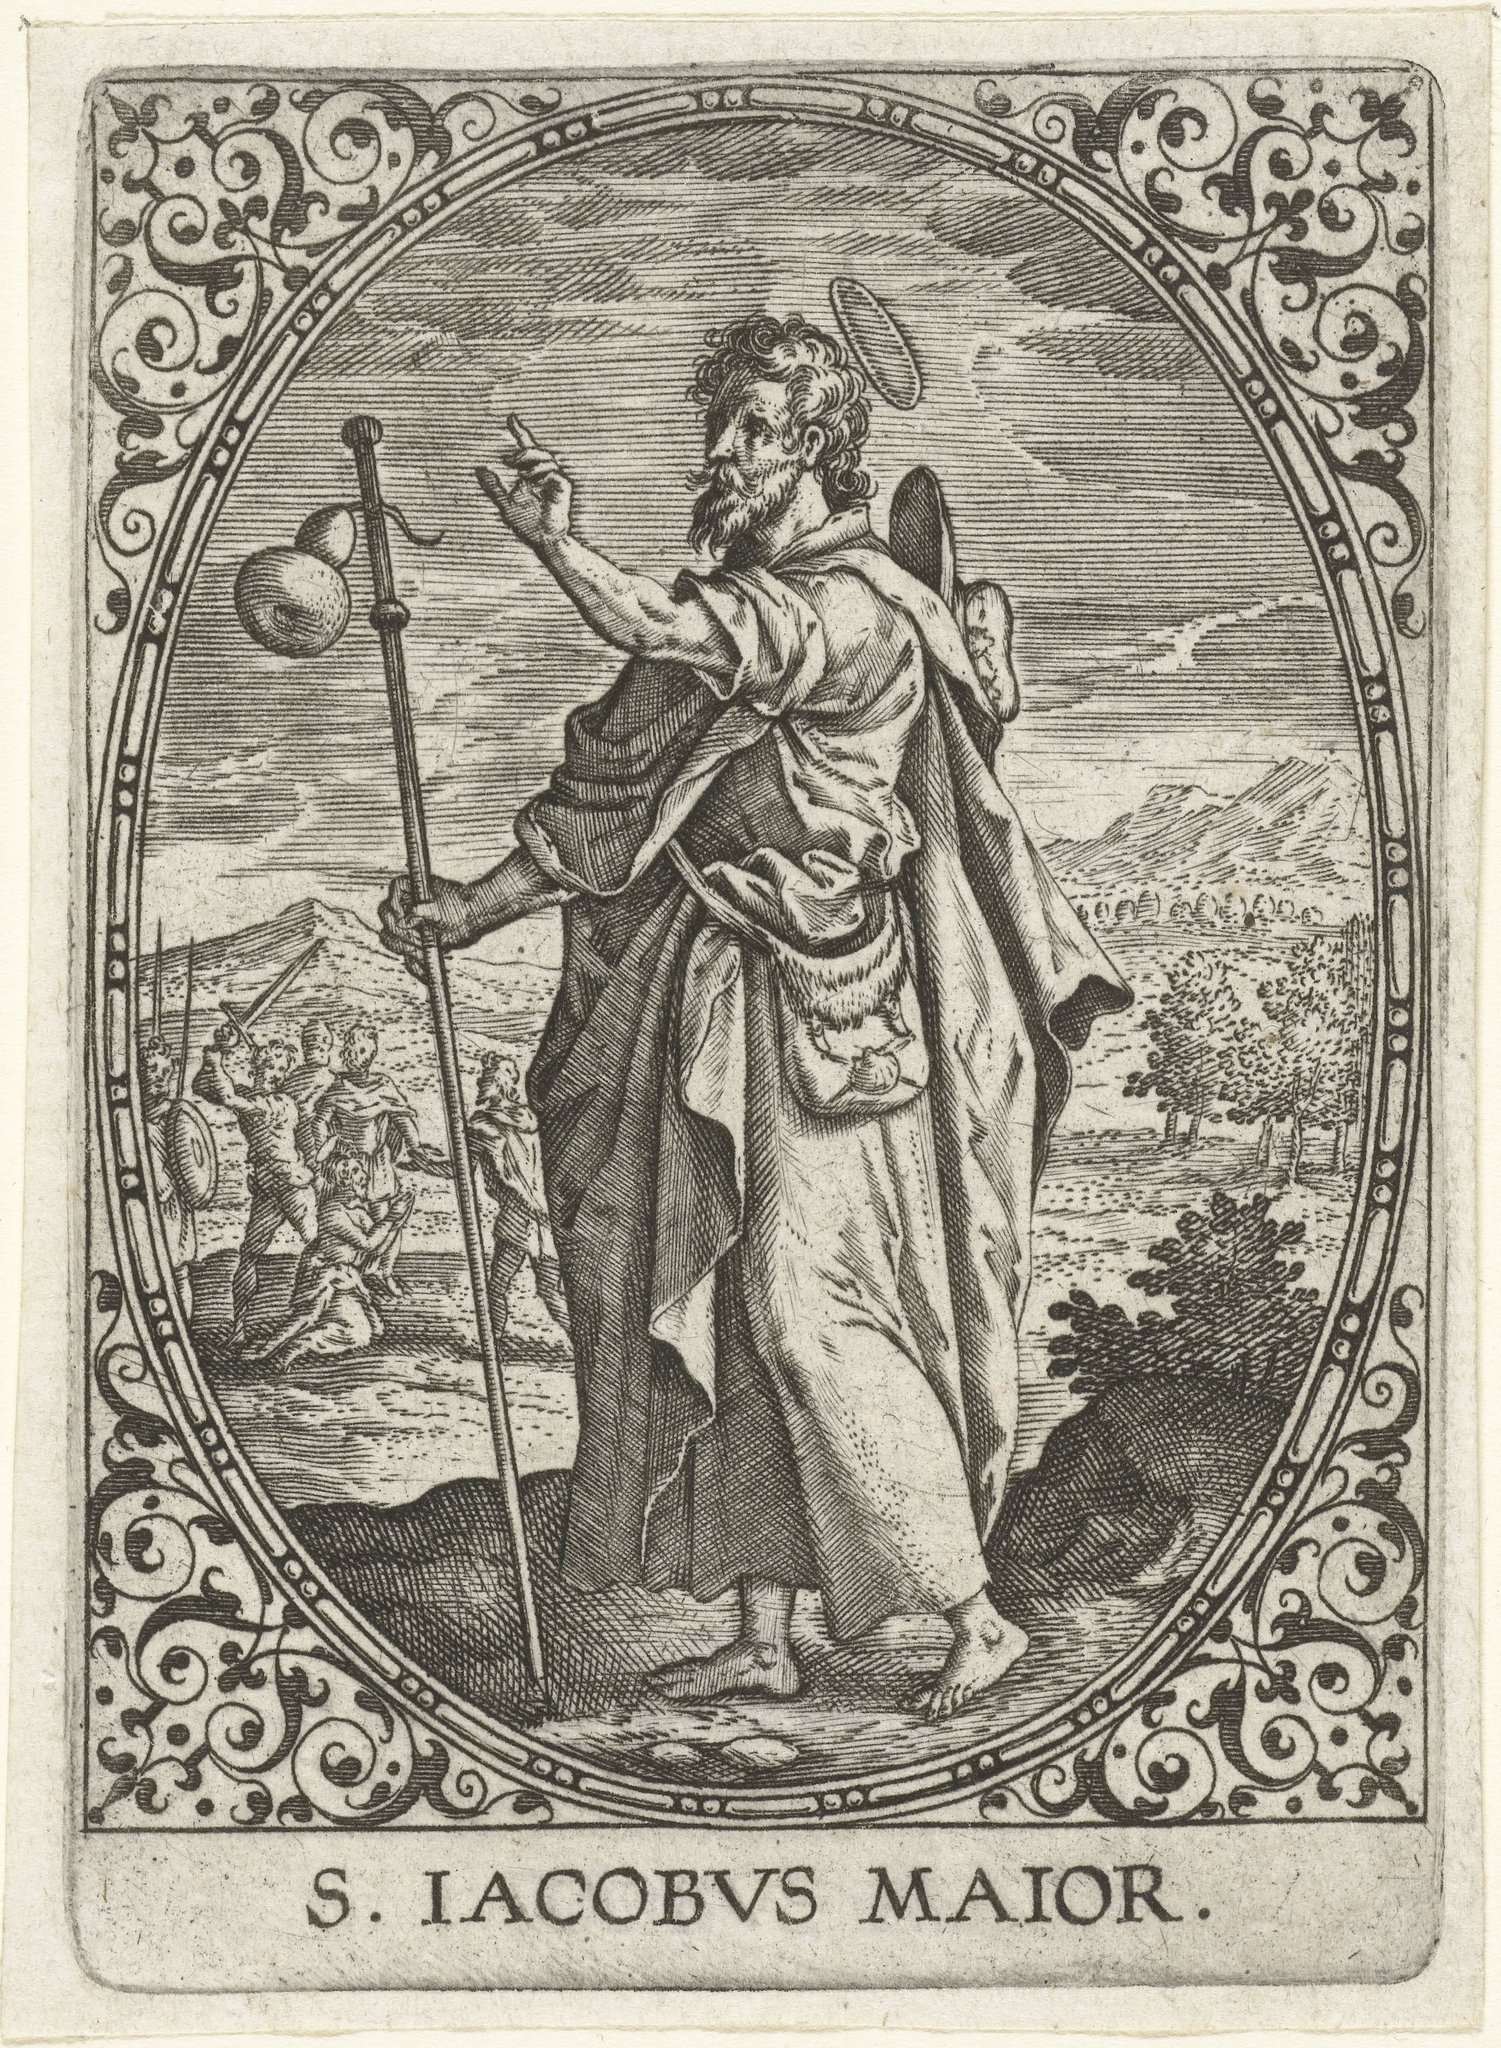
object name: print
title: S. Iacobvs Maior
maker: adriaen collaert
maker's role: draughtsman, print maker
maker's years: 1560-1618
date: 1570-1618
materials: paper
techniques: engraving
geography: antwerp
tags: the apostle james the great; possible attributes: book, pilgrim's cloak, hat, shell, staff, and wallet, scroll, sword - martyrdom, suffering, misfortune, death of male saint, the apostle james the great; possible attributes: book, pilgrim's cloak, hat, shell, staff, and wallet, scroll, sword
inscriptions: collector's mark: Lugt 2760, collector's mark: Lugt 2228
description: De apostel Jakobus de Meerdere in een ovaal medaillon. Hij houdt een pelgrimsstaf vast. Op de achtergrond zijn marteldood door onthoofding.